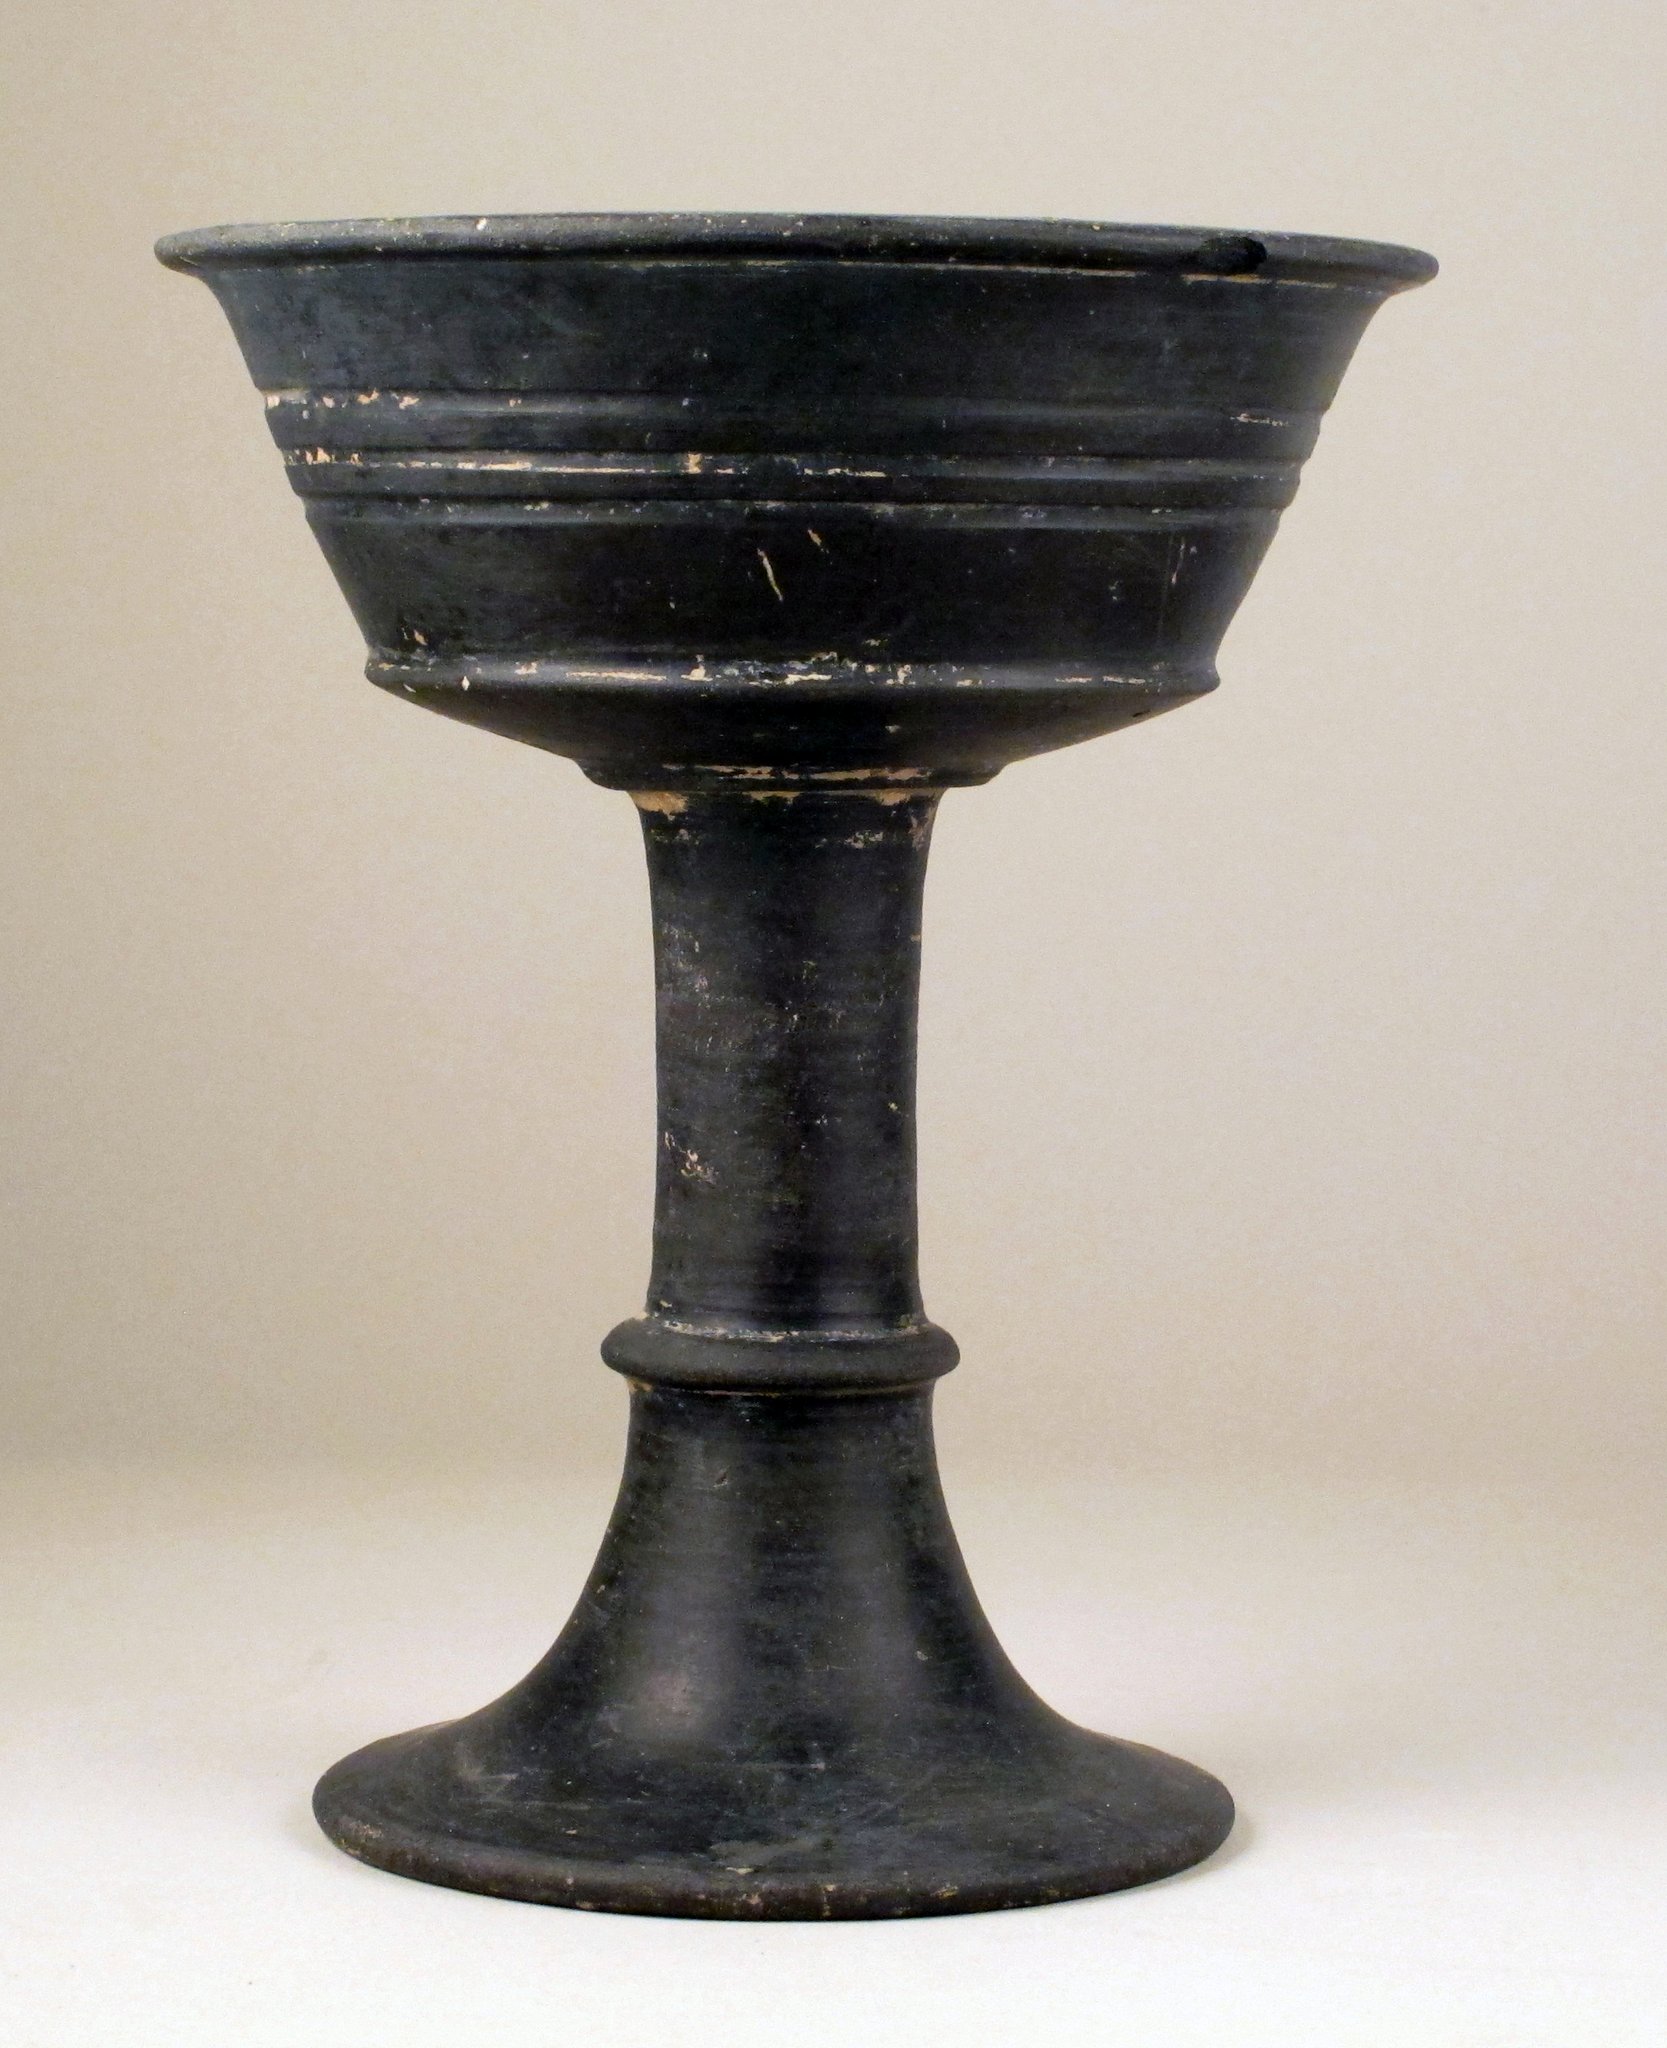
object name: cup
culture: etruscan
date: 600-551 BCE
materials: terracotta